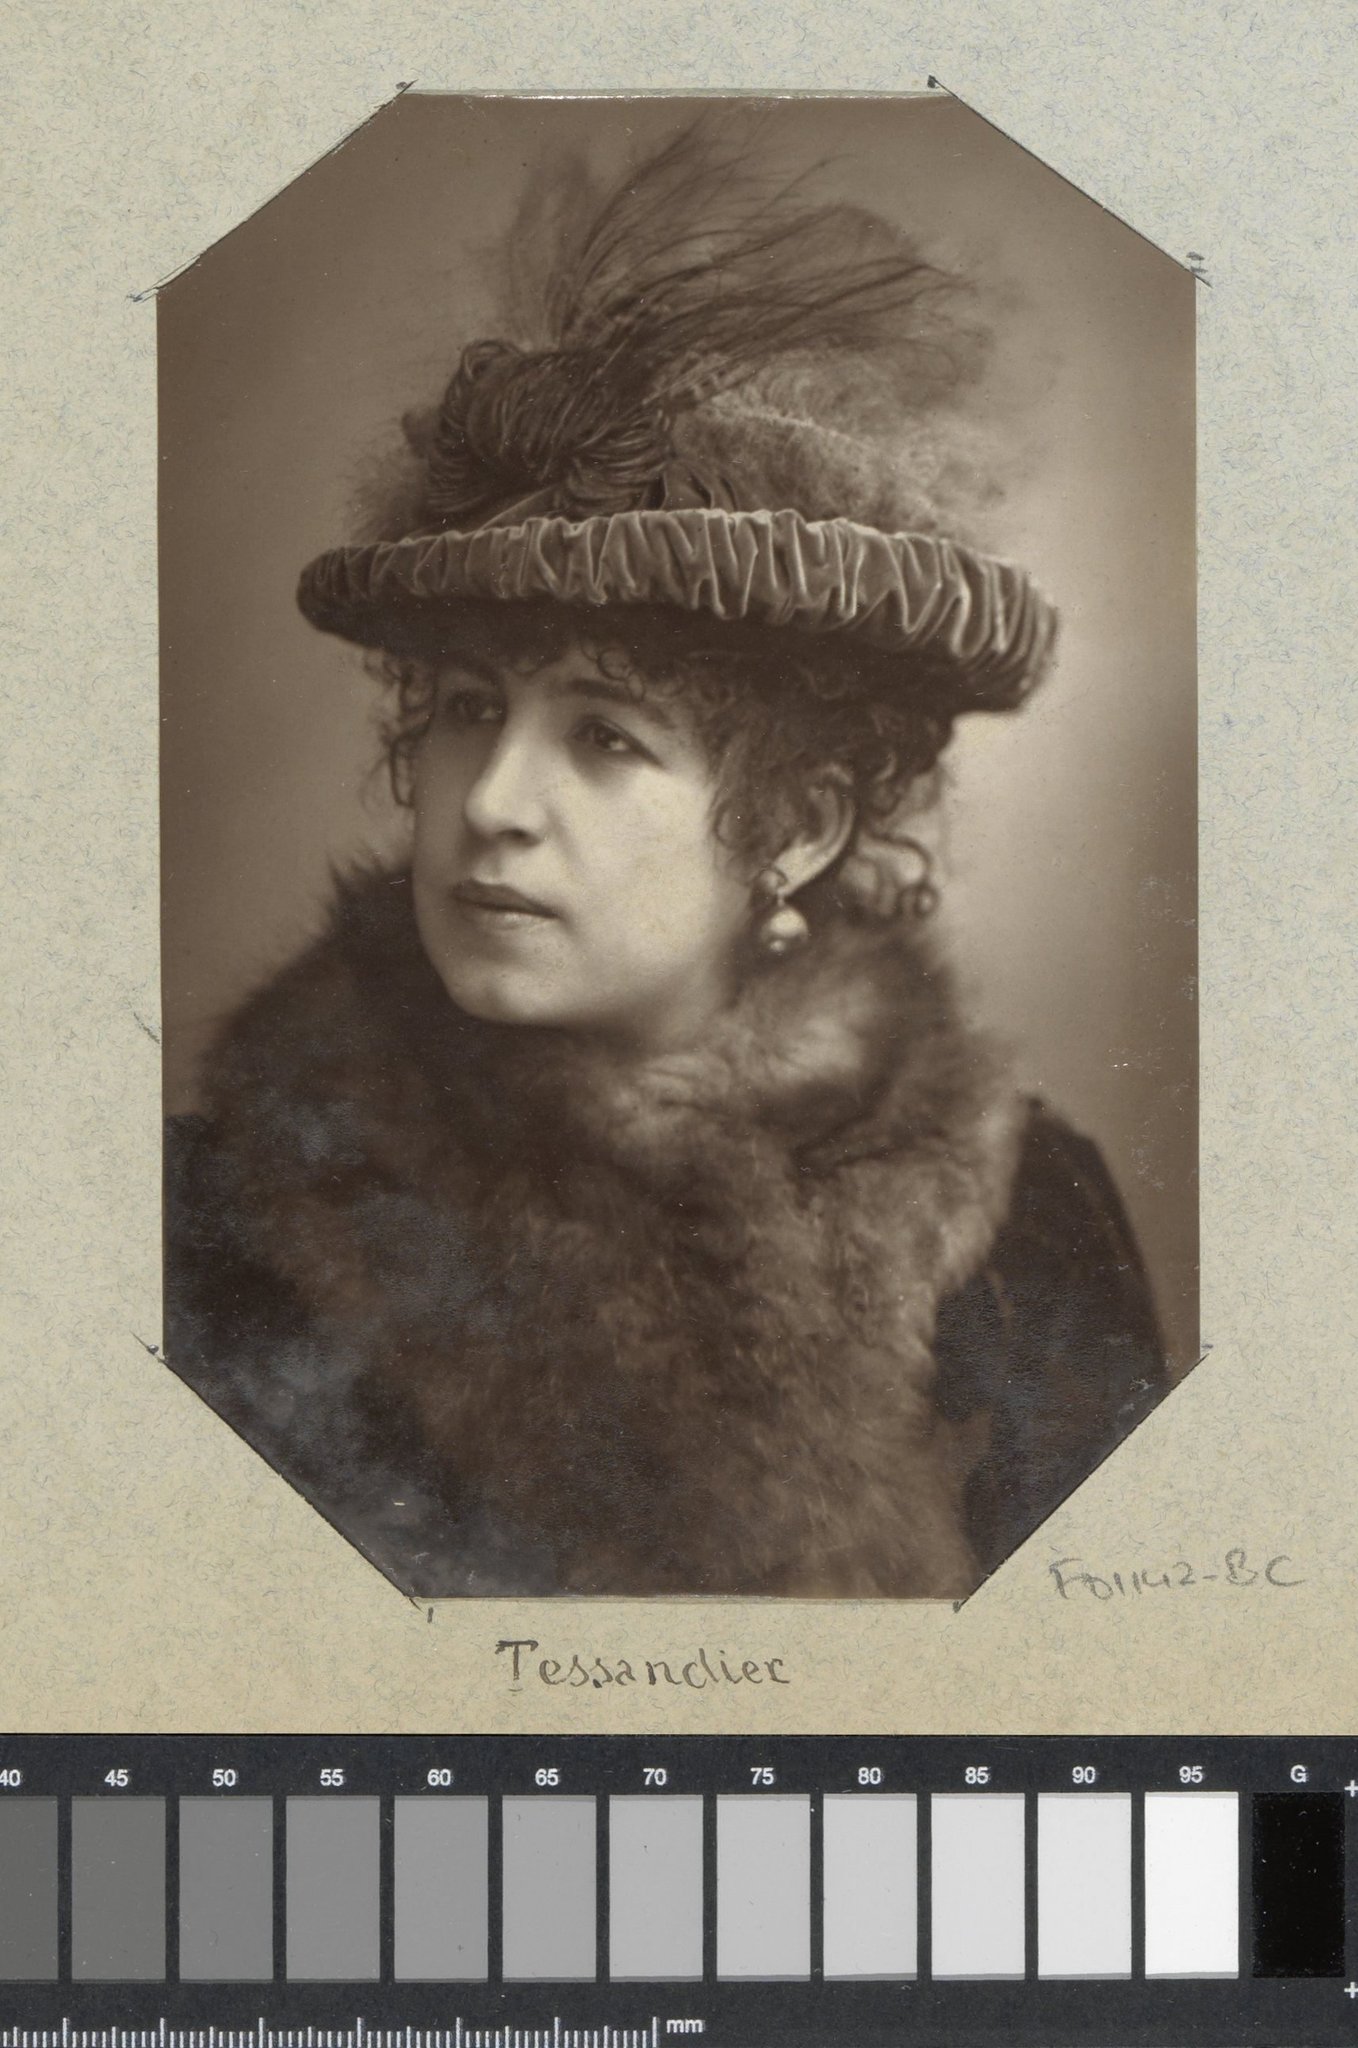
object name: album leaf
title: Portret van Aimée Tessandier, actrice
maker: Anonymous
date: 1890-1900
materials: paper, photographic support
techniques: carbon print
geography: france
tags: portrait of actor, actress, france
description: Onderdeel van Album van een Franse amateur met foto's van Frankrijk, Algerije, Palmyra, de Wereldtentoonstelling van 1900 en van bekende Fransen.